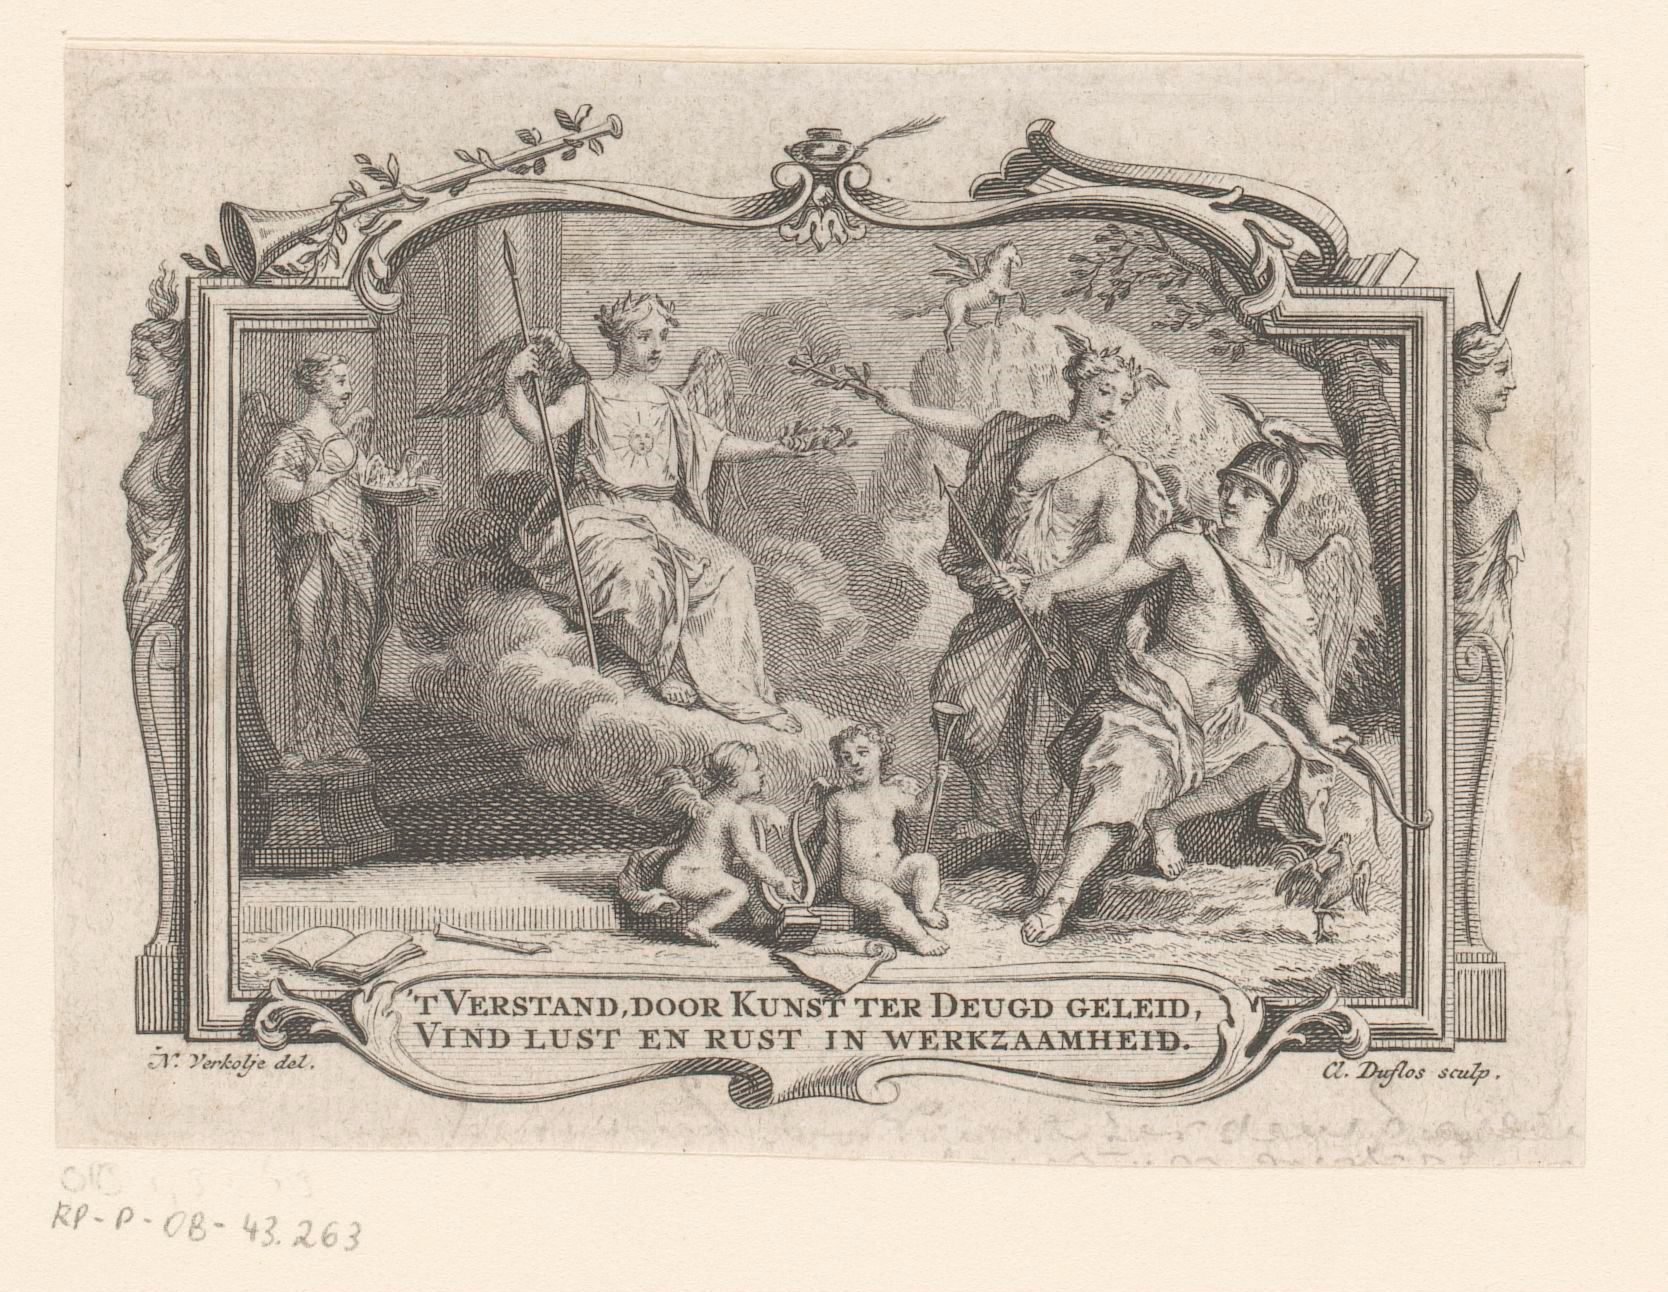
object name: titelblad, titelpagina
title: Titelpagina voor: Sybrand Feitema, Toneelpoëzy van S.F. onder de Zinspreuk Studio Fovetur Ingenium, 1735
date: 1735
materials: paper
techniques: engraving, etching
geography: amsterdam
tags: pegasus, the winged horse, intellect, intelligence; 'intelletto', 'intelligenza' (ripa), symbolic representations, allegories and emblems ~ art; 'arte' (ripa)